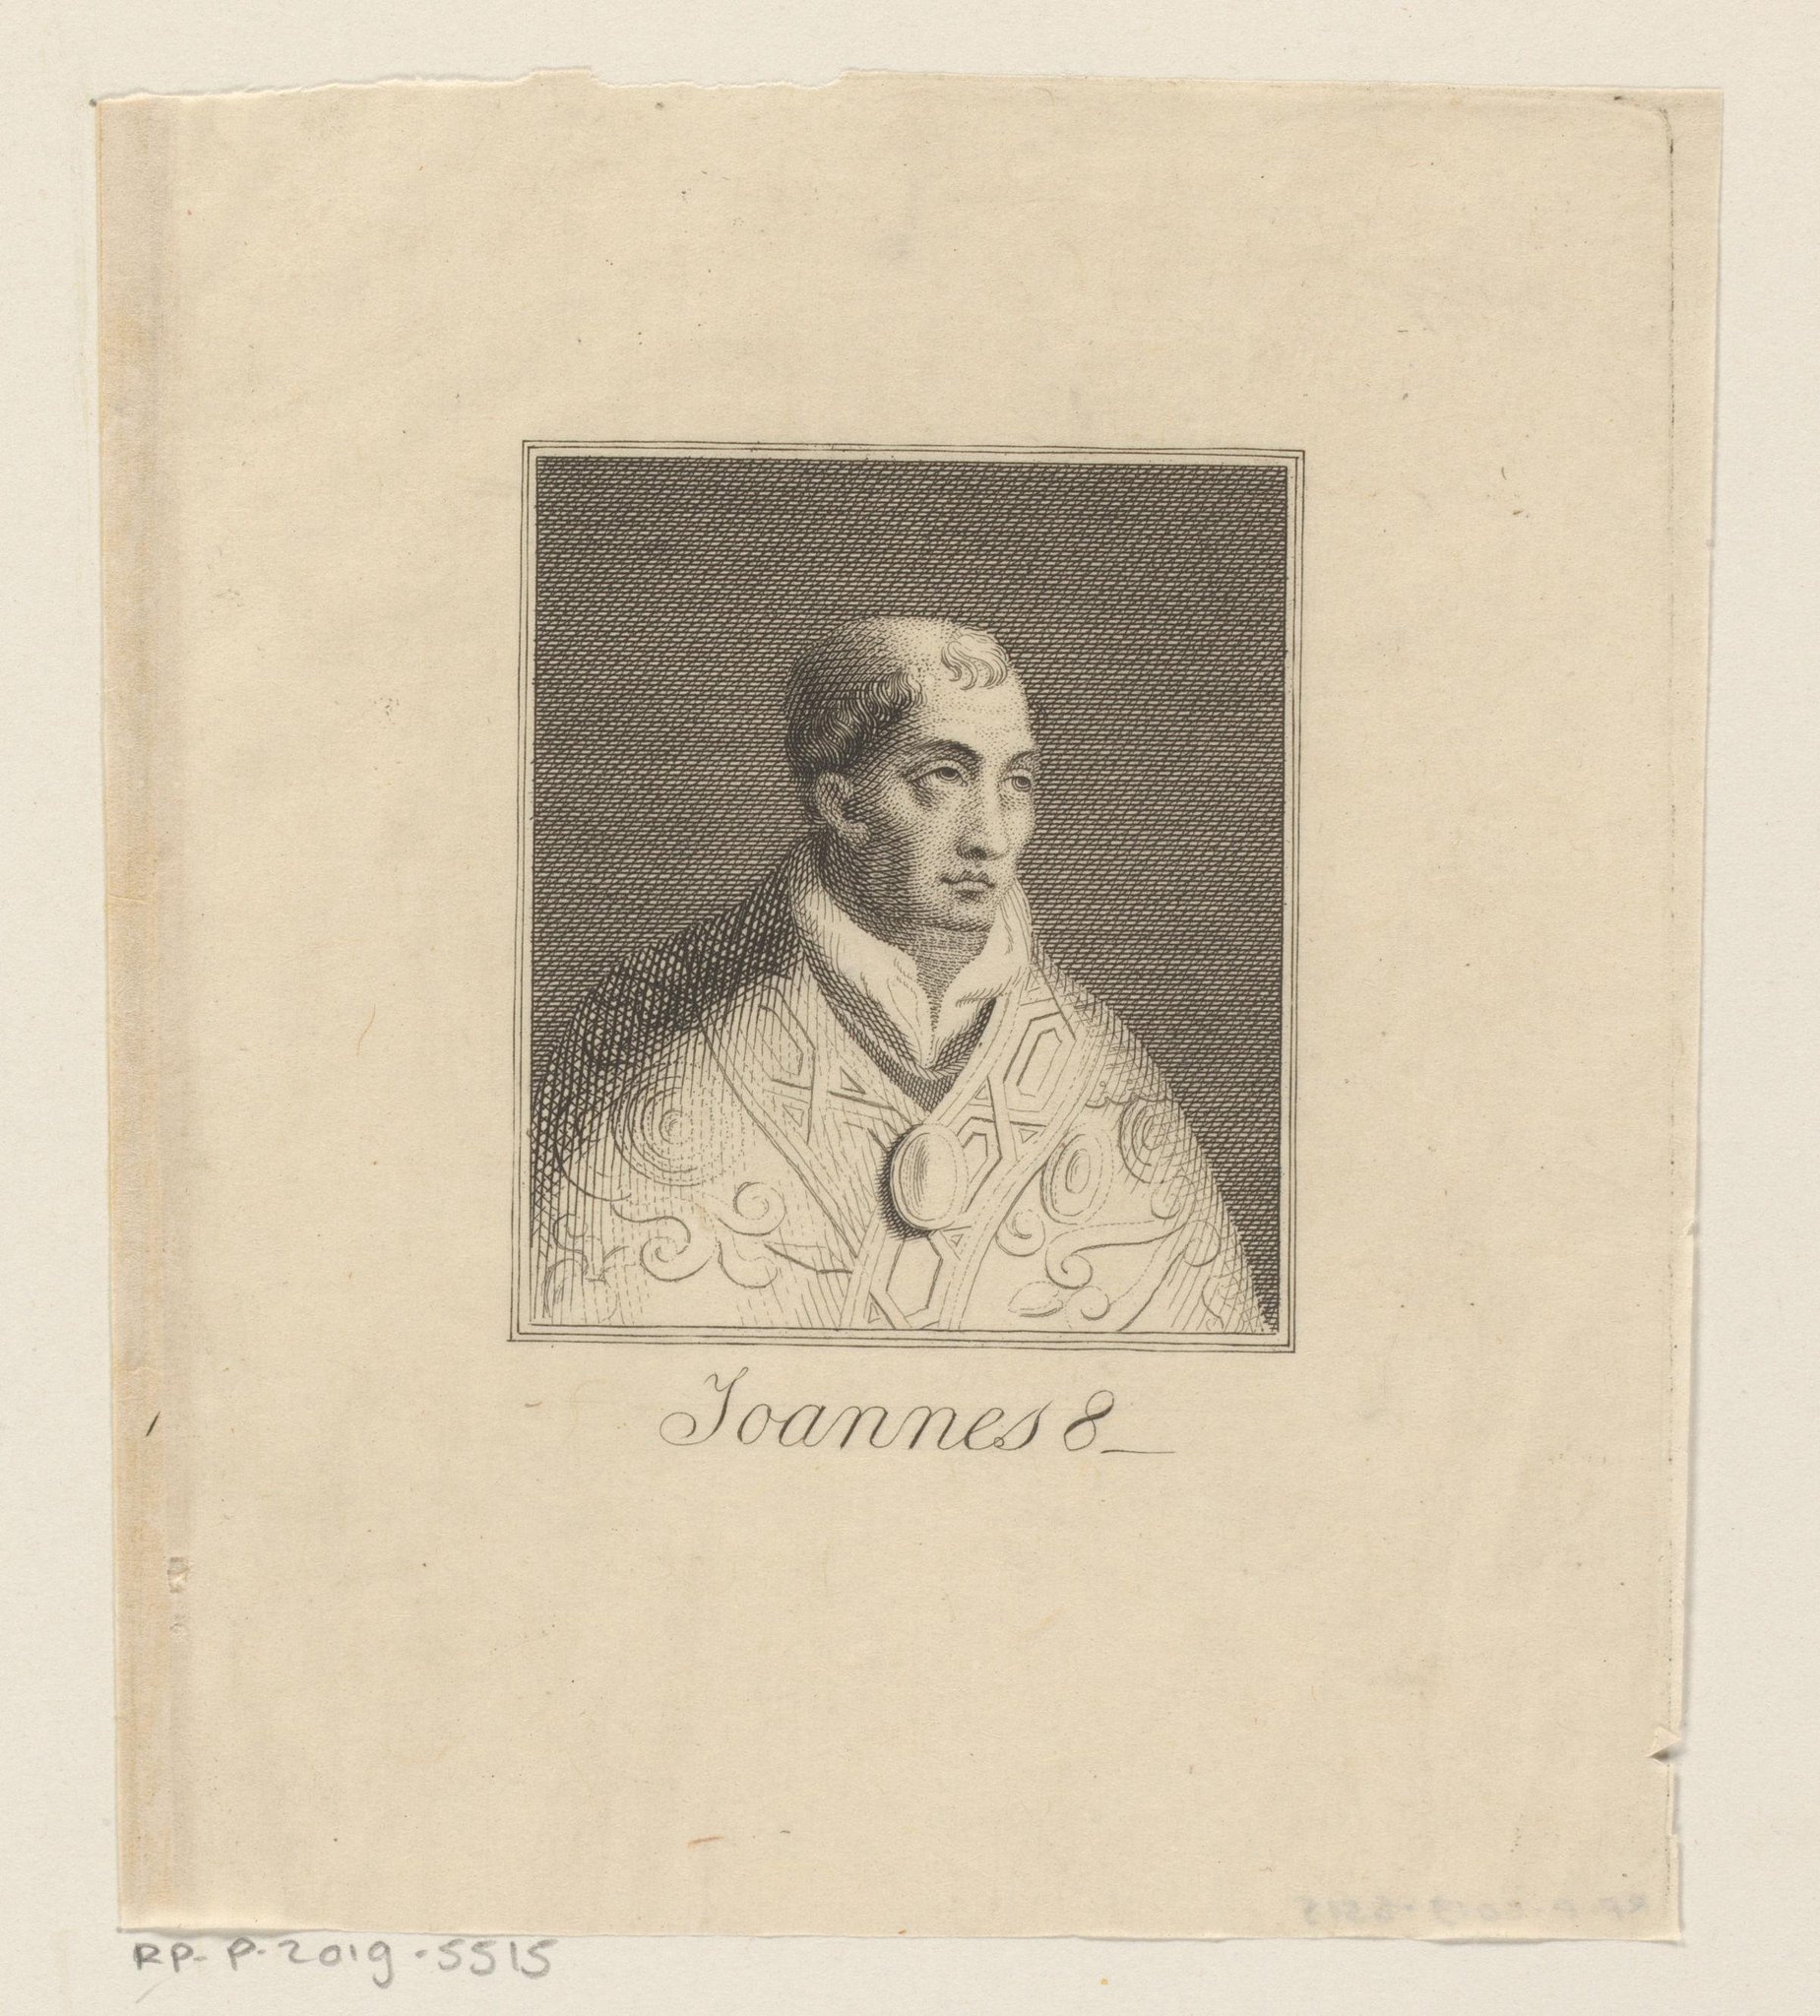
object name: print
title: Portret van paus Johannes VIII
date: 1799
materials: paper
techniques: engraving, etching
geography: london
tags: rome, historical persons, pope